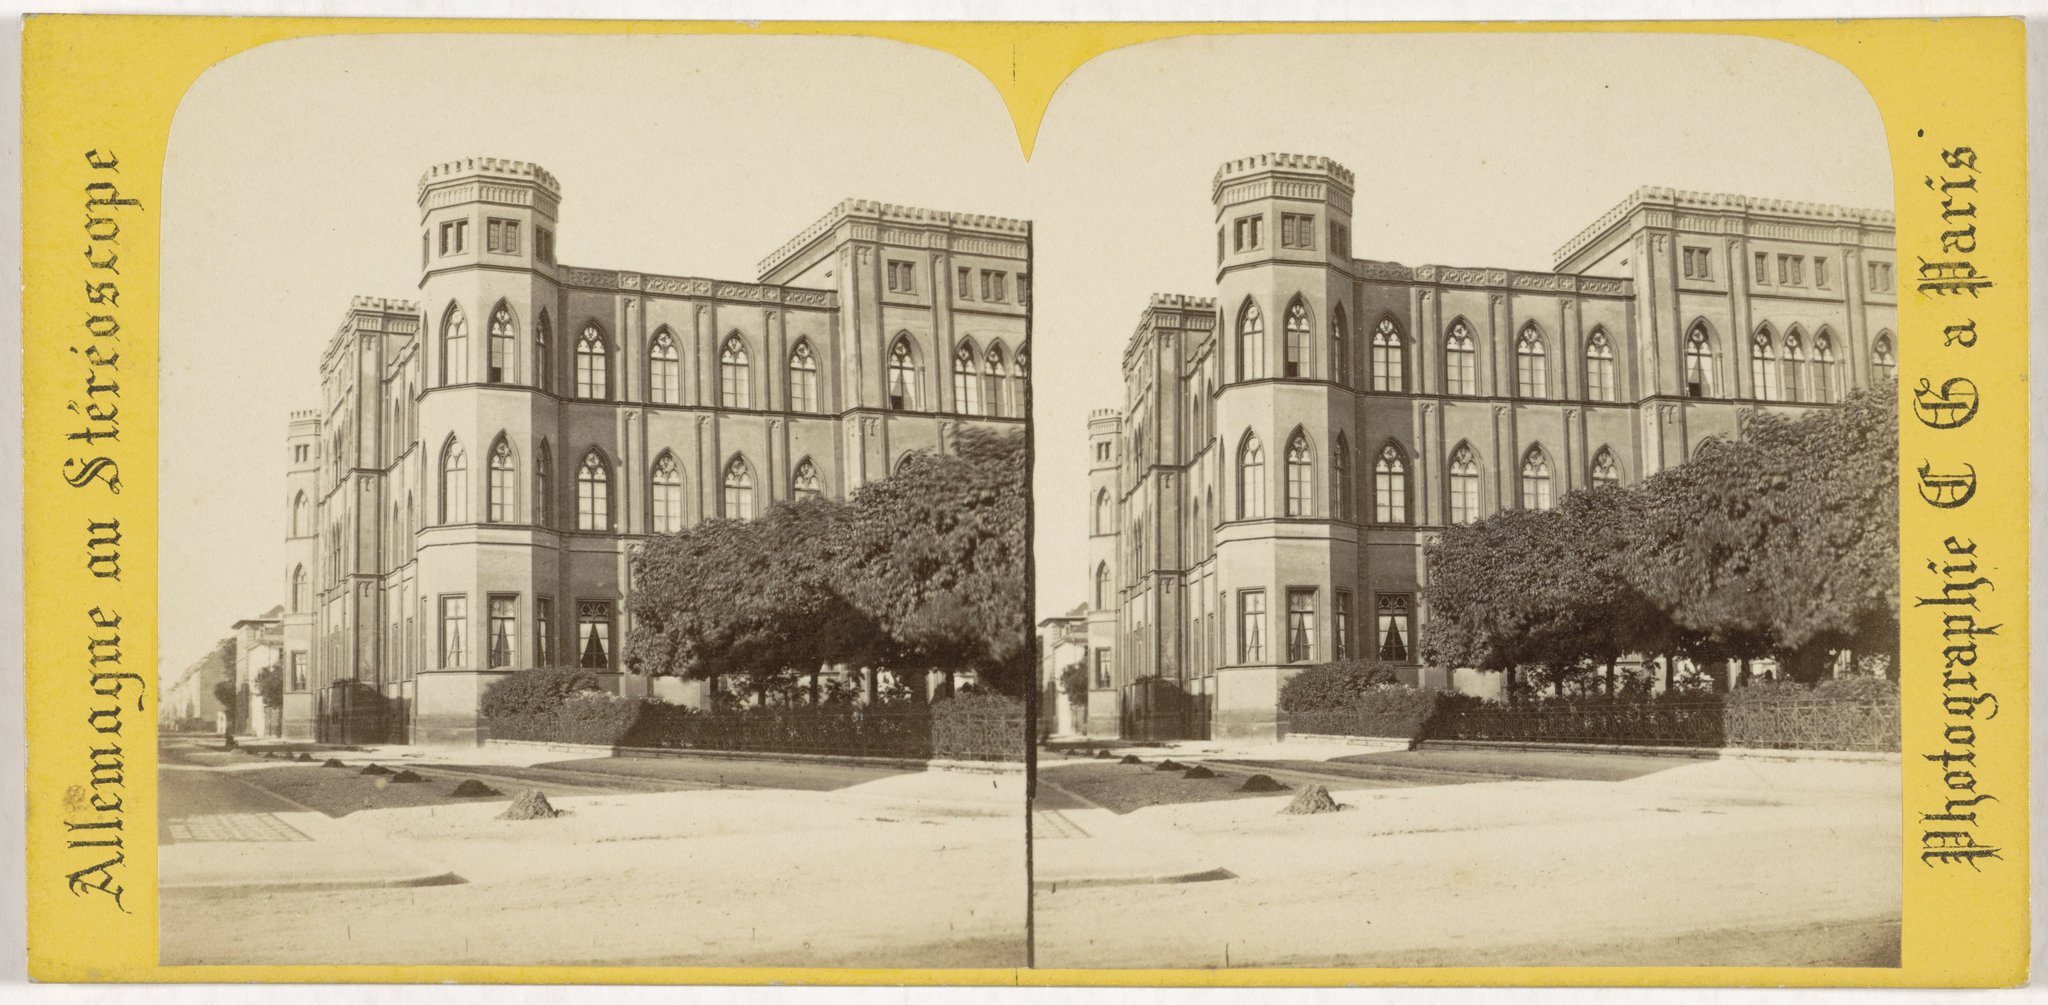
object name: stereograph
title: Allemagne au stéréoscope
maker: charles gaudin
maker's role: publisher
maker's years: 1825-1905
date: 1868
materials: cardboard, paper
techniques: albumen print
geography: munich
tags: palace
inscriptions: inscription: ‘60’, number: ‘48.’